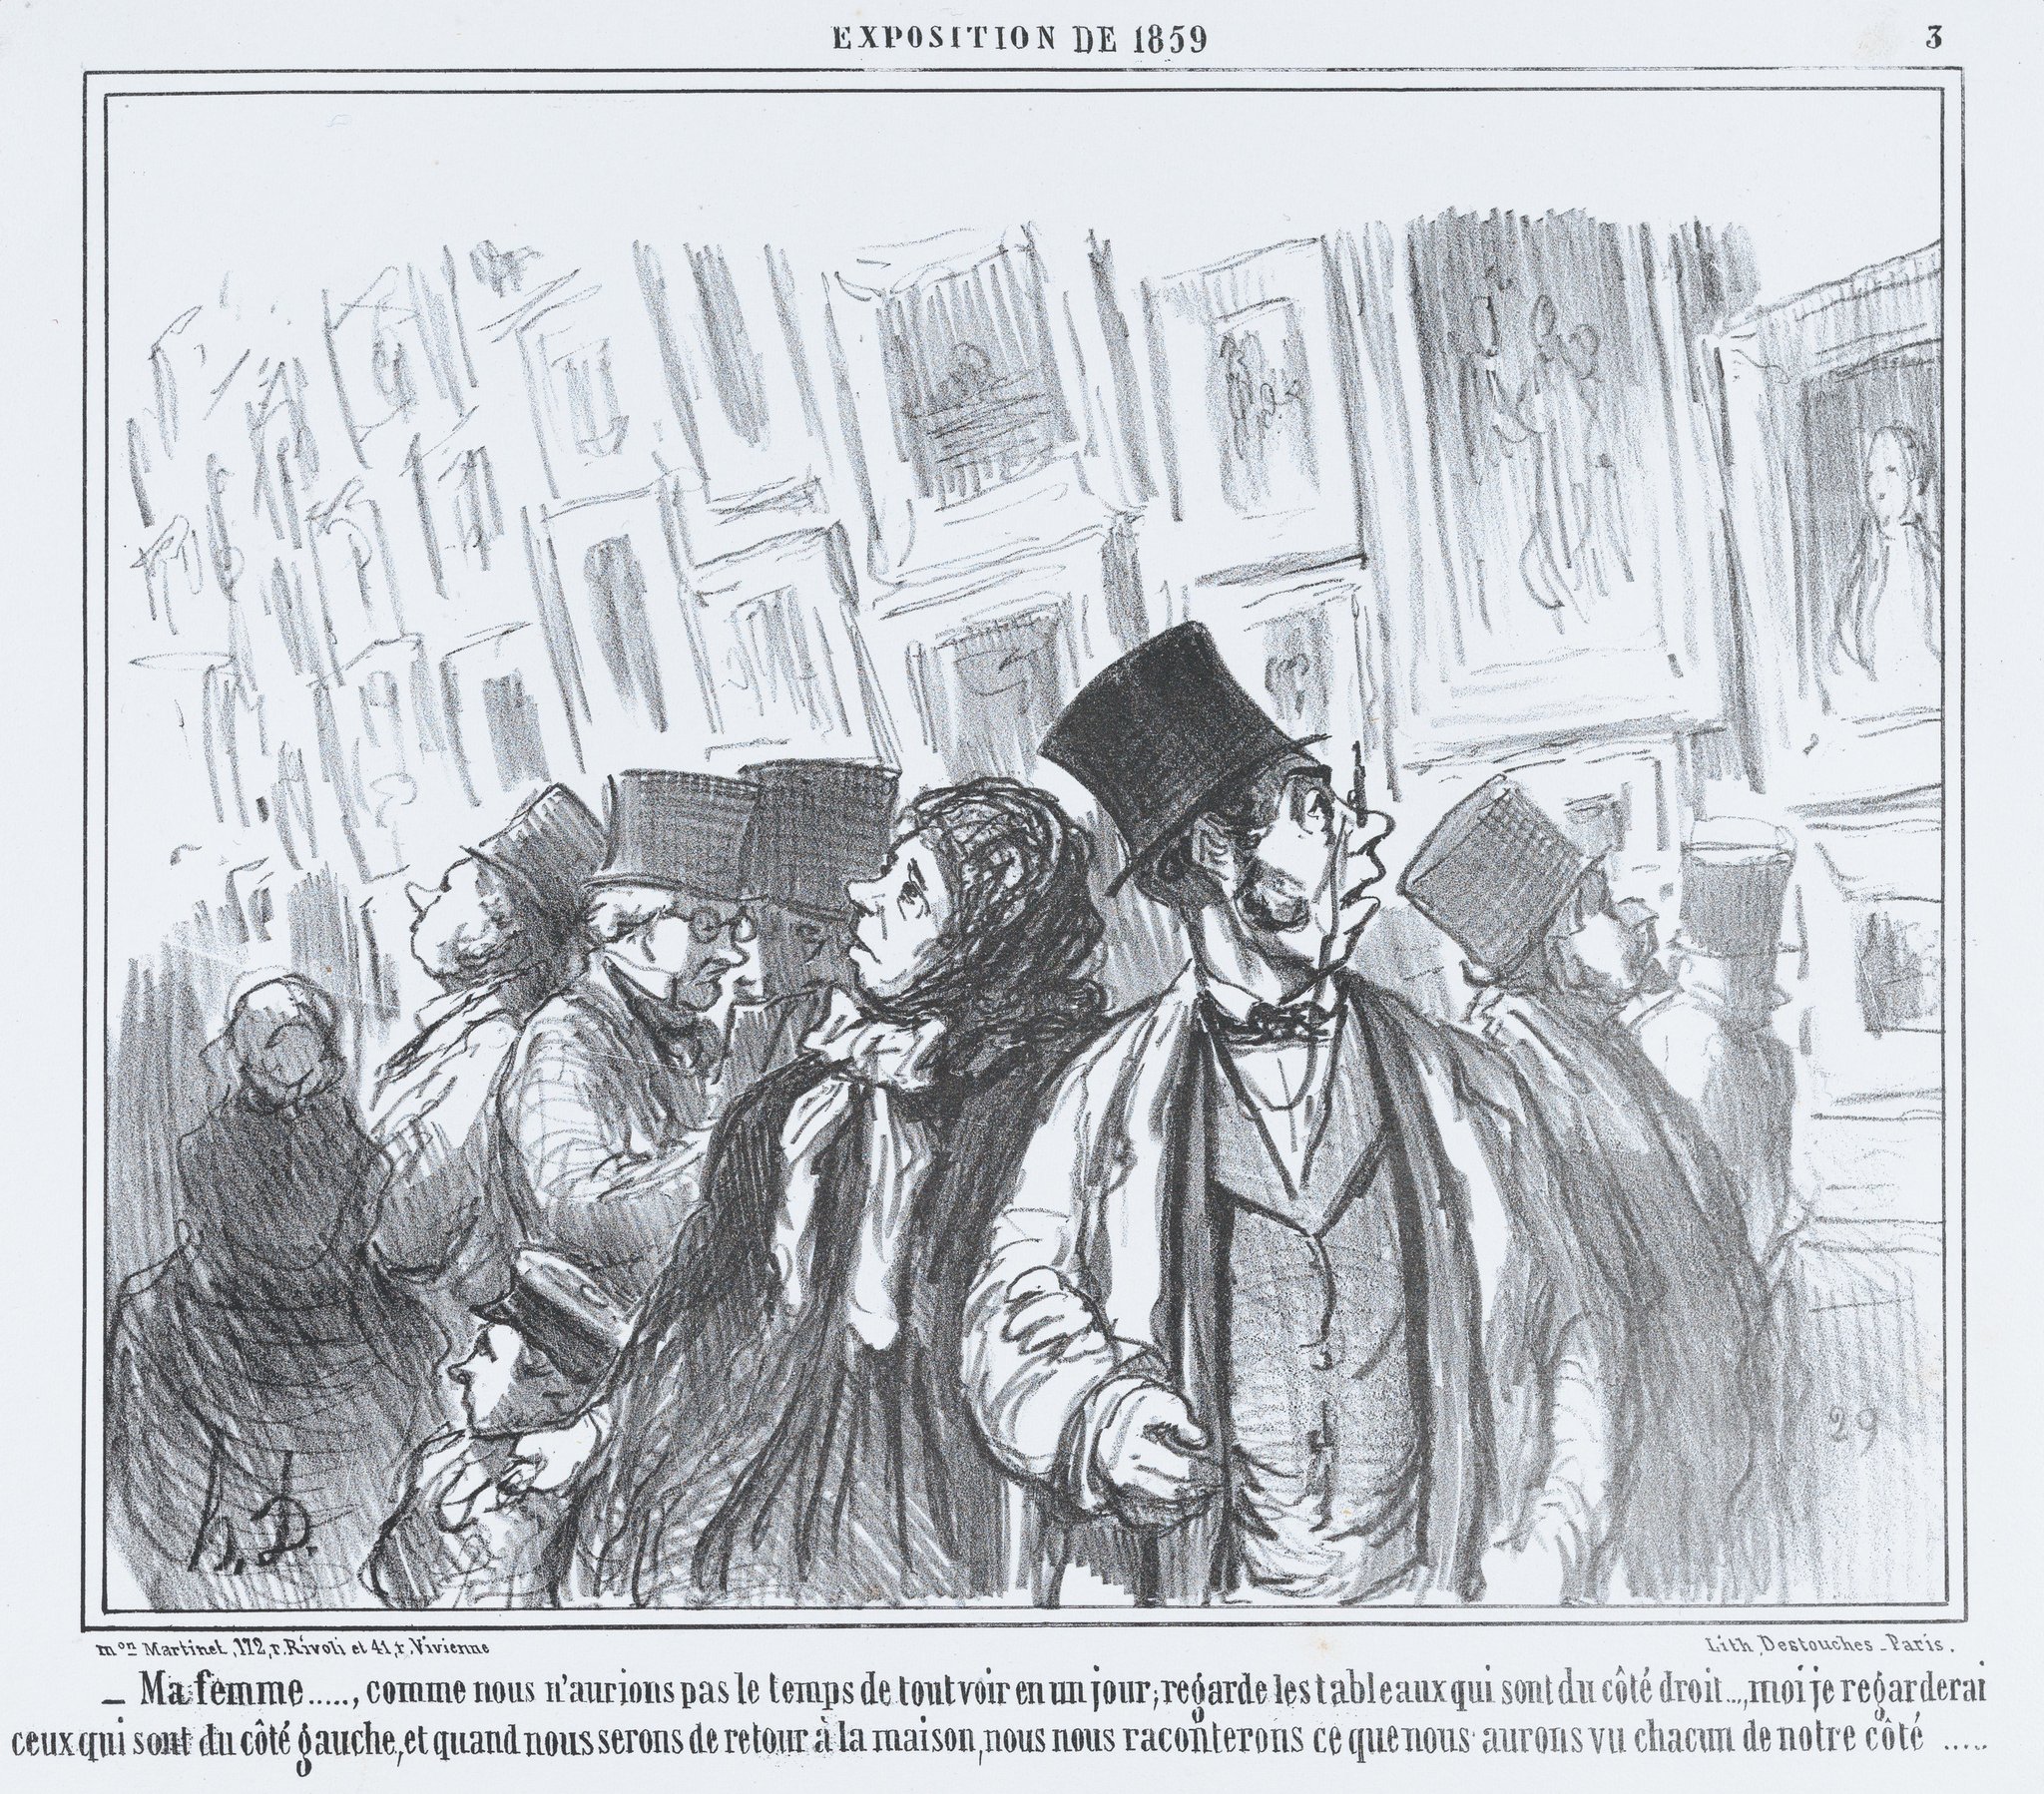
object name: print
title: Ma femme..., comme nous n'aurions pas le temps de tout voir en un jour..., from L'Exposition de 1859, published in Le Charivari, April 18, 1859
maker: honoré daumier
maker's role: artist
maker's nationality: french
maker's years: 1808-1879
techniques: lithograph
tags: men,women